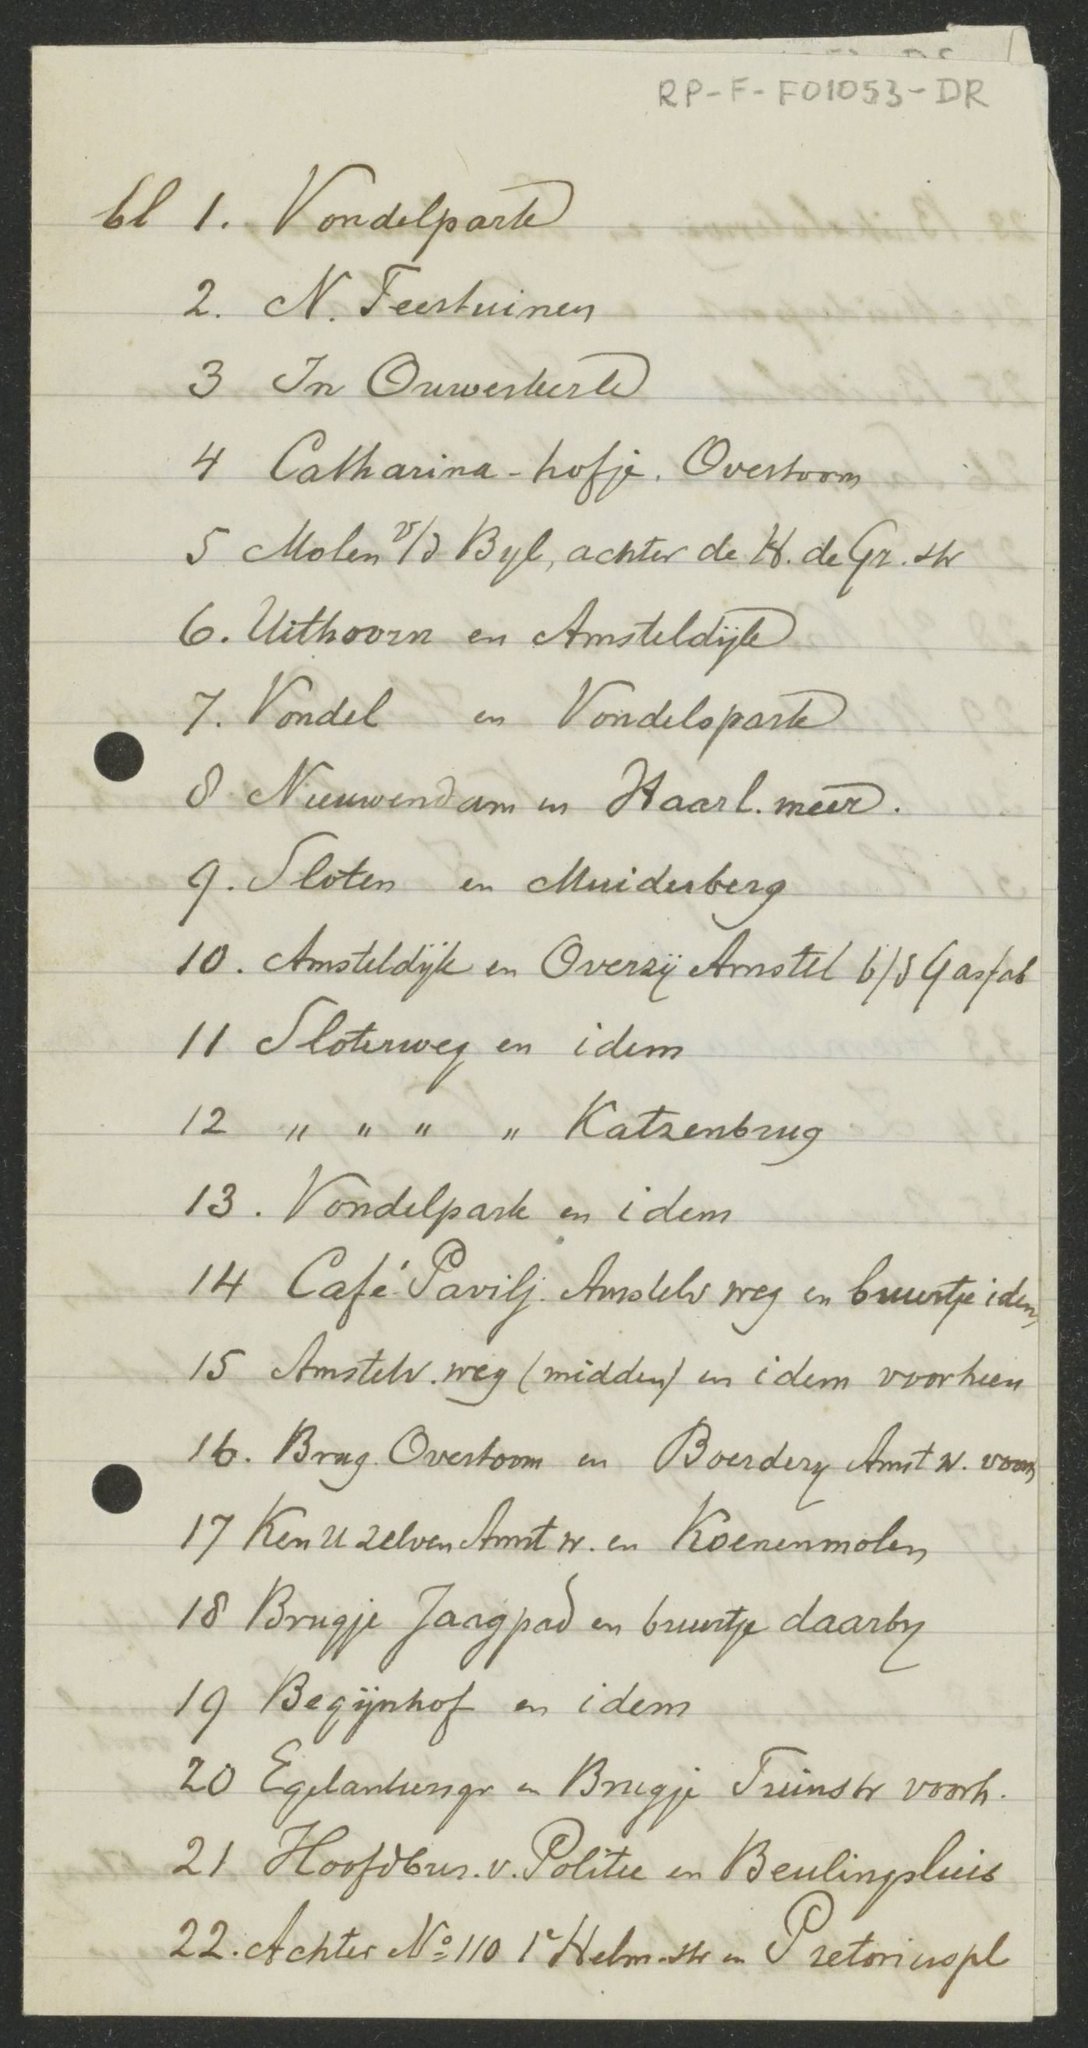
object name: list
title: Lijst met in het album afgebeelde onderwerpen (blad 1 t/m 22)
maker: Anonymous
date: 1930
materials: paper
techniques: writing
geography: netherlands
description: Onderdeel van Album met foto's van Amsterdam en omgeving.